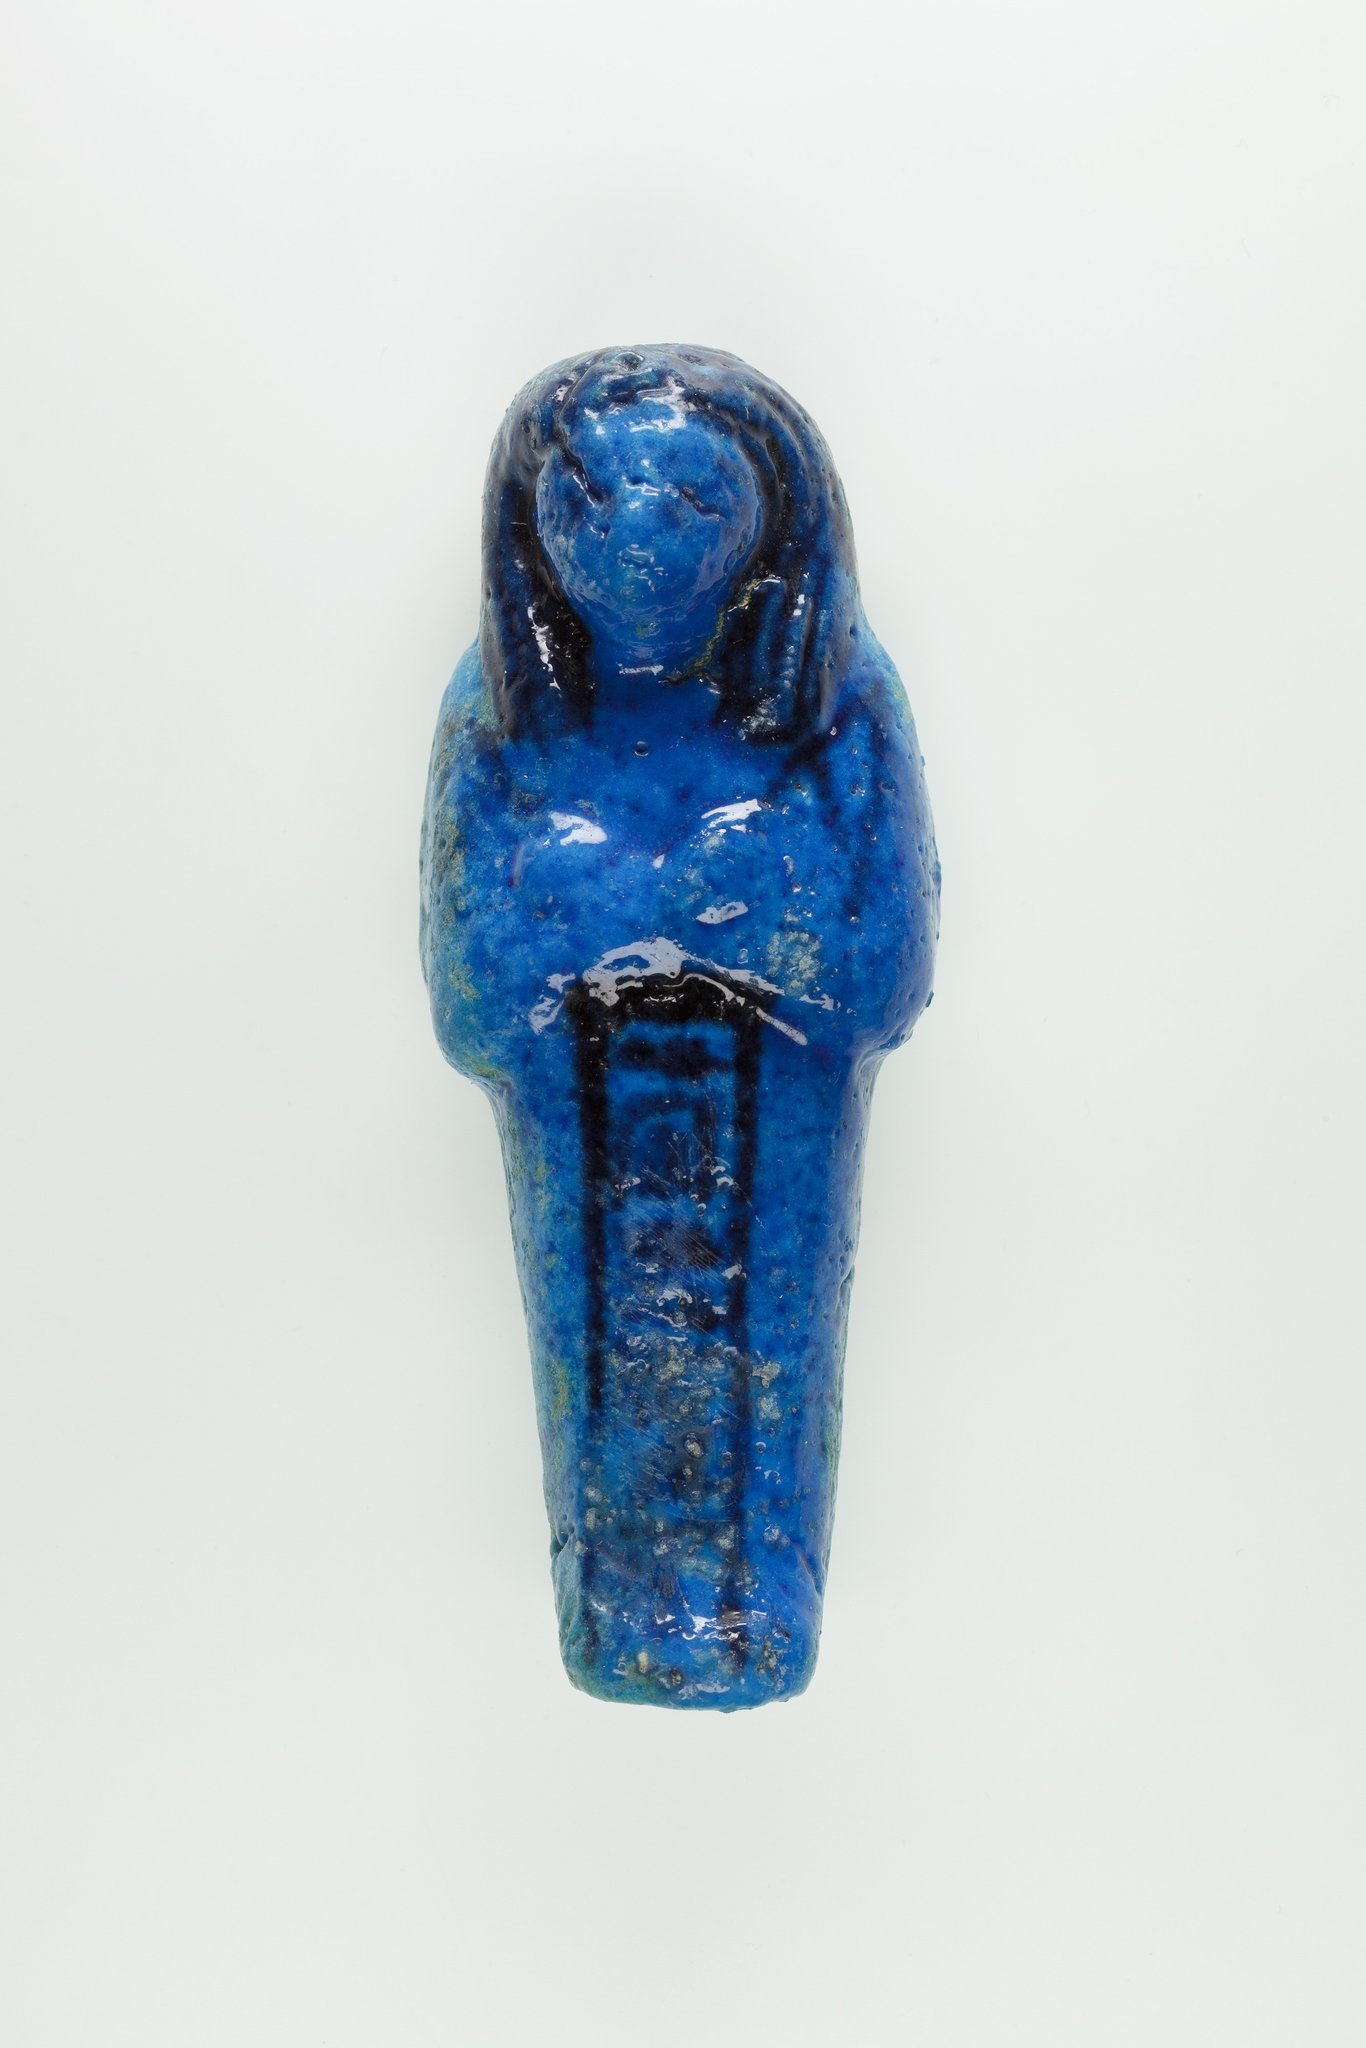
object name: shabti, worker, nauny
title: Worker Shabti of Nauny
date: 1050 BCE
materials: faience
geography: egypt